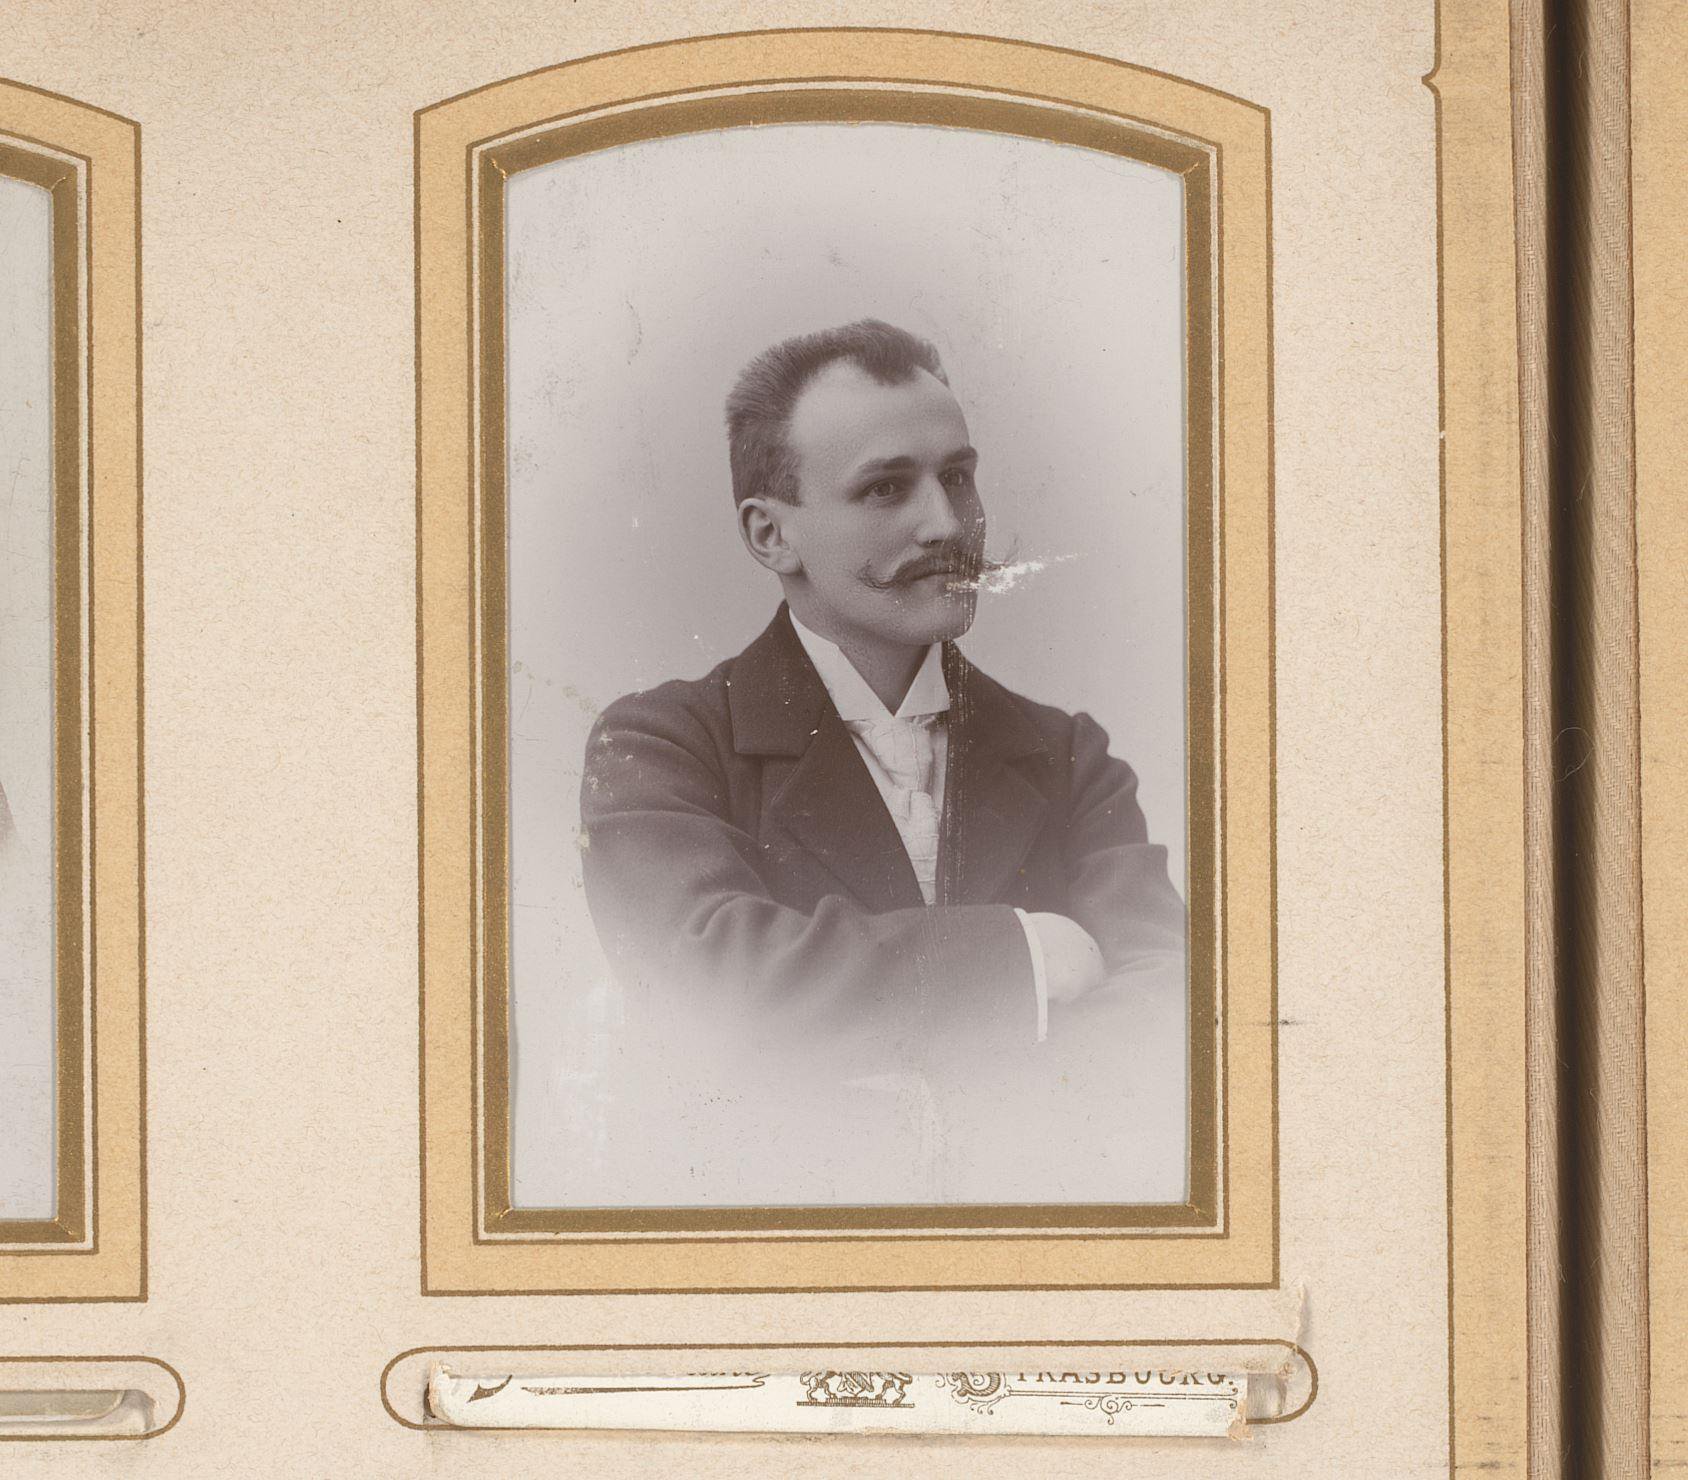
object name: album leaf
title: Portret van een man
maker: gerschel aîné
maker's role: fotograaf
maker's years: 1828-1898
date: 1880-1920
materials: cardboard, photographic support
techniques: collodion silver print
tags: adult man, historical persons